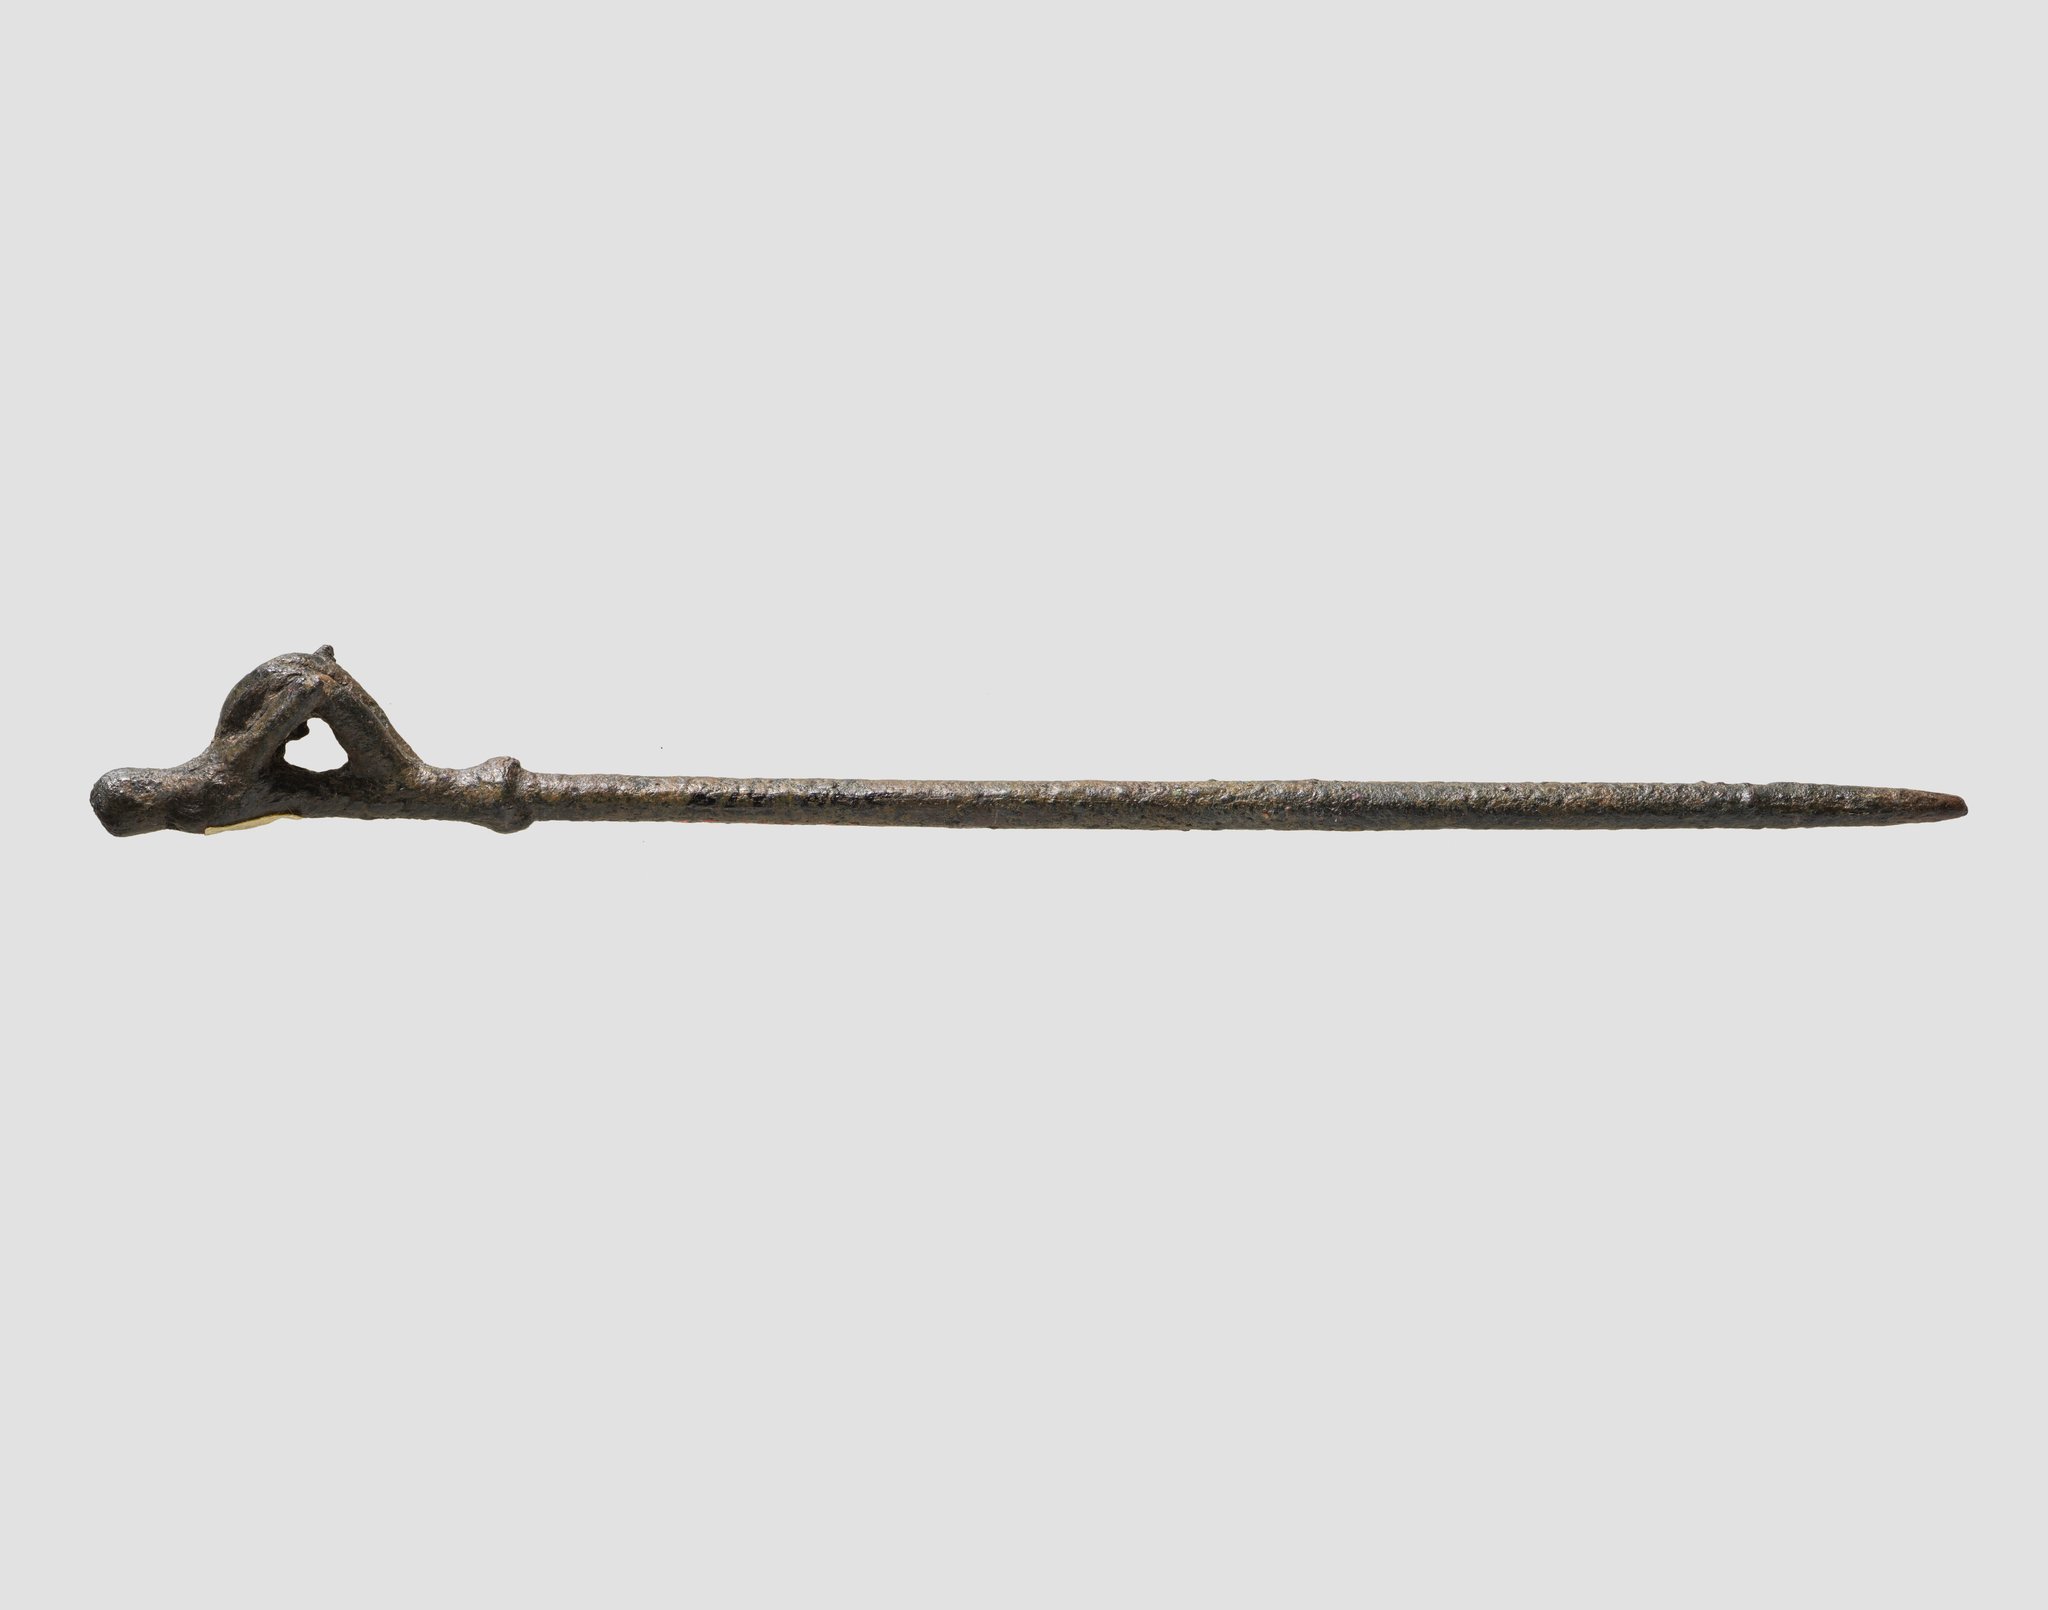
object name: pin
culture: iranian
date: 800-601 BCE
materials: bronze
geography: iran, luristan